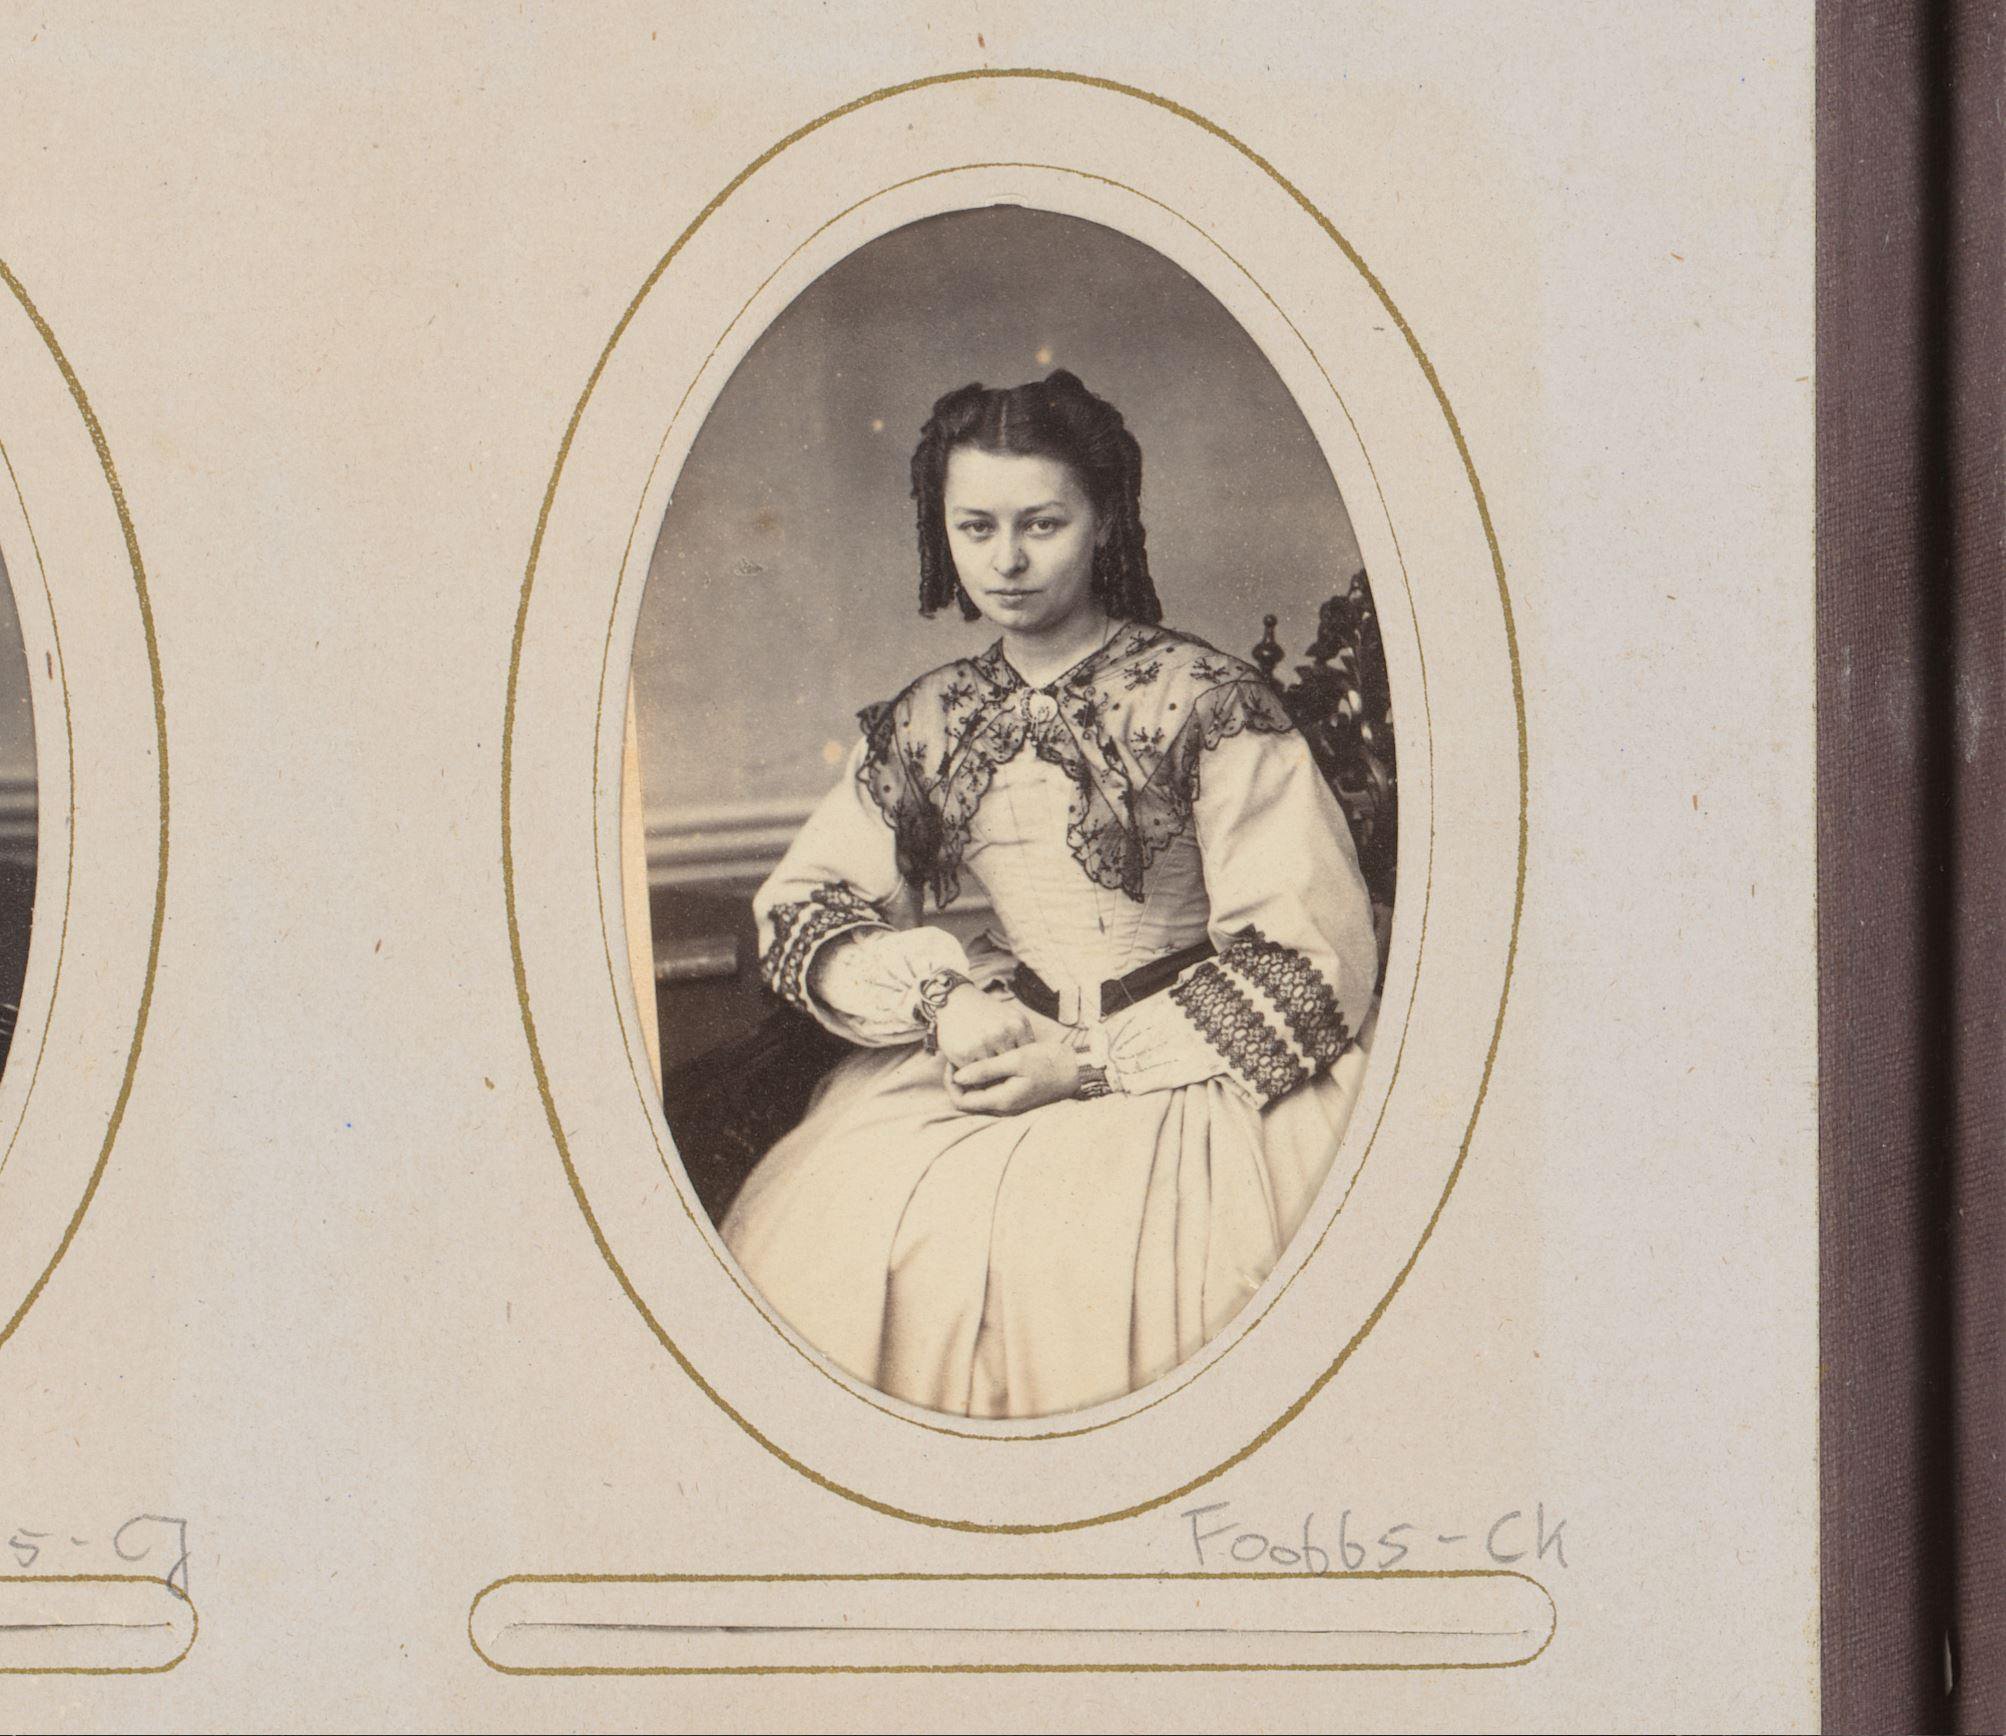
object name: album leaf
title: Portret van een meisje met zwart kanten schouderdoek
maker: eduard fuchs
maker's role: painter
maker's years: 1832-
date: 1859-1870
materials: cardboard, photographic support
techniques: albumen print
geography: leeuwarden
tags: adolescent, young woman, maiden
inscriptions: inscription: ‘Photographie/ E. Fuchs/ Leeuwarden’